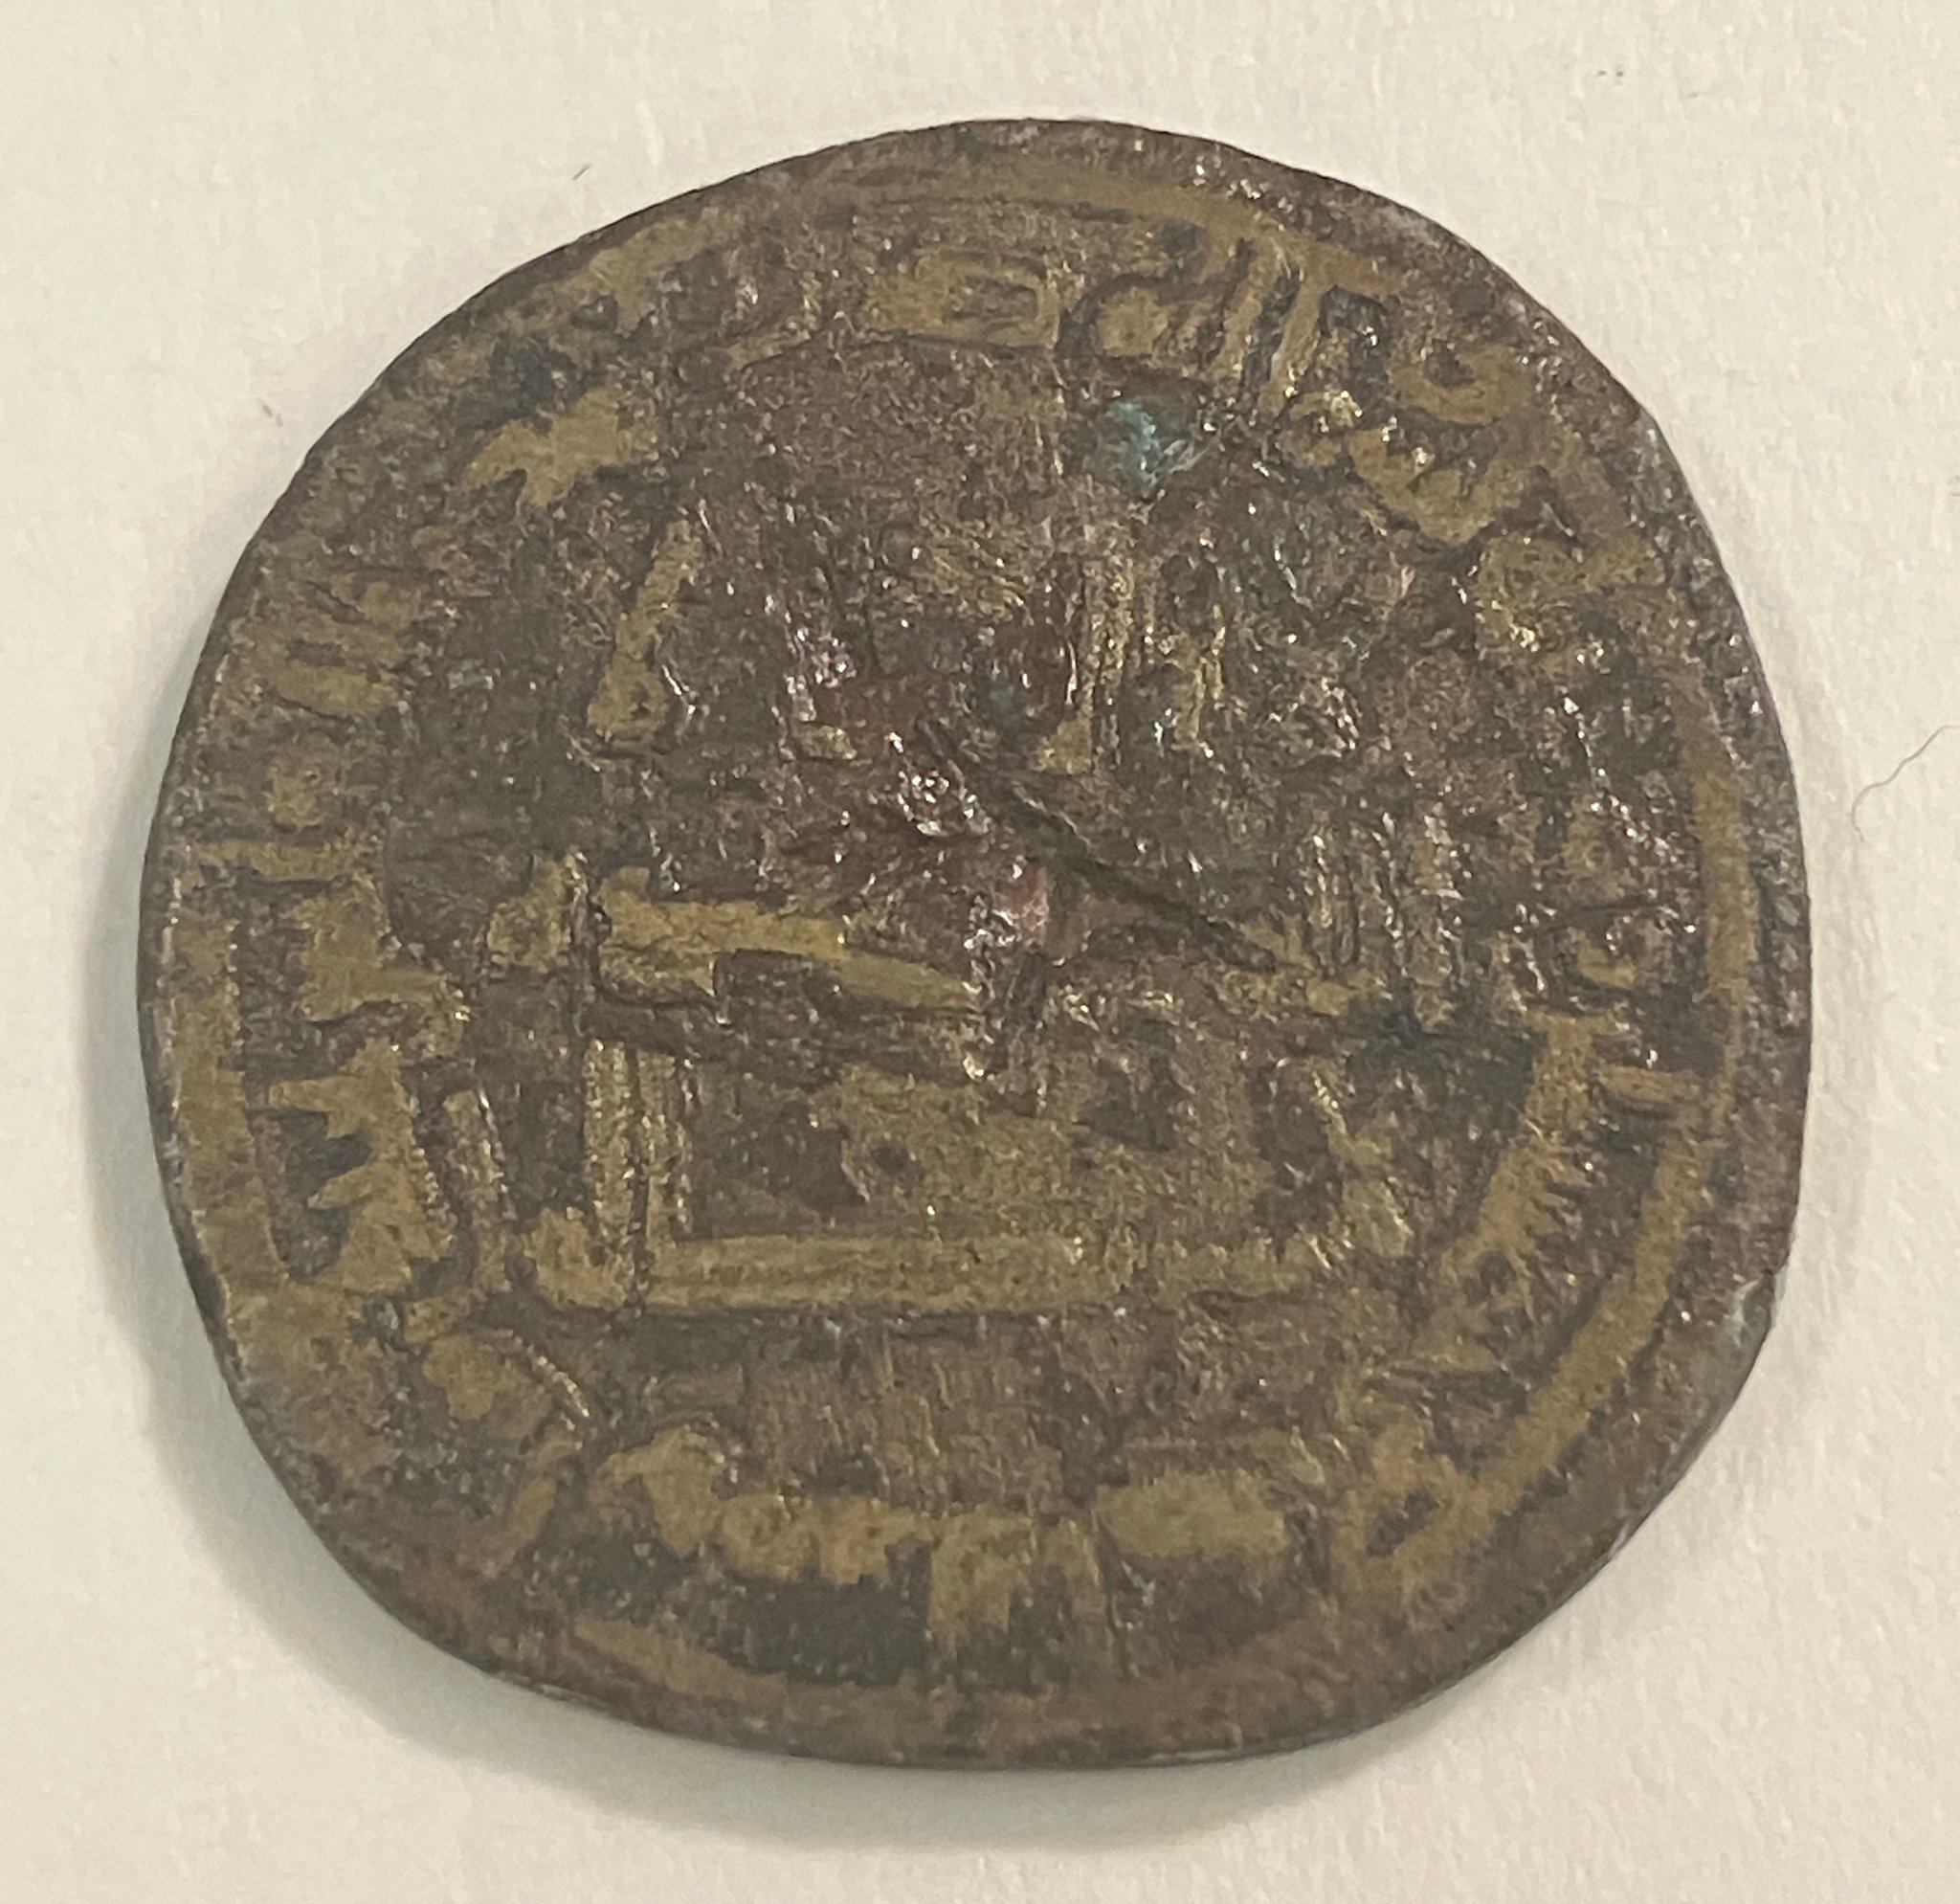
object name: coin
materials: copper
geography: jundi shapur